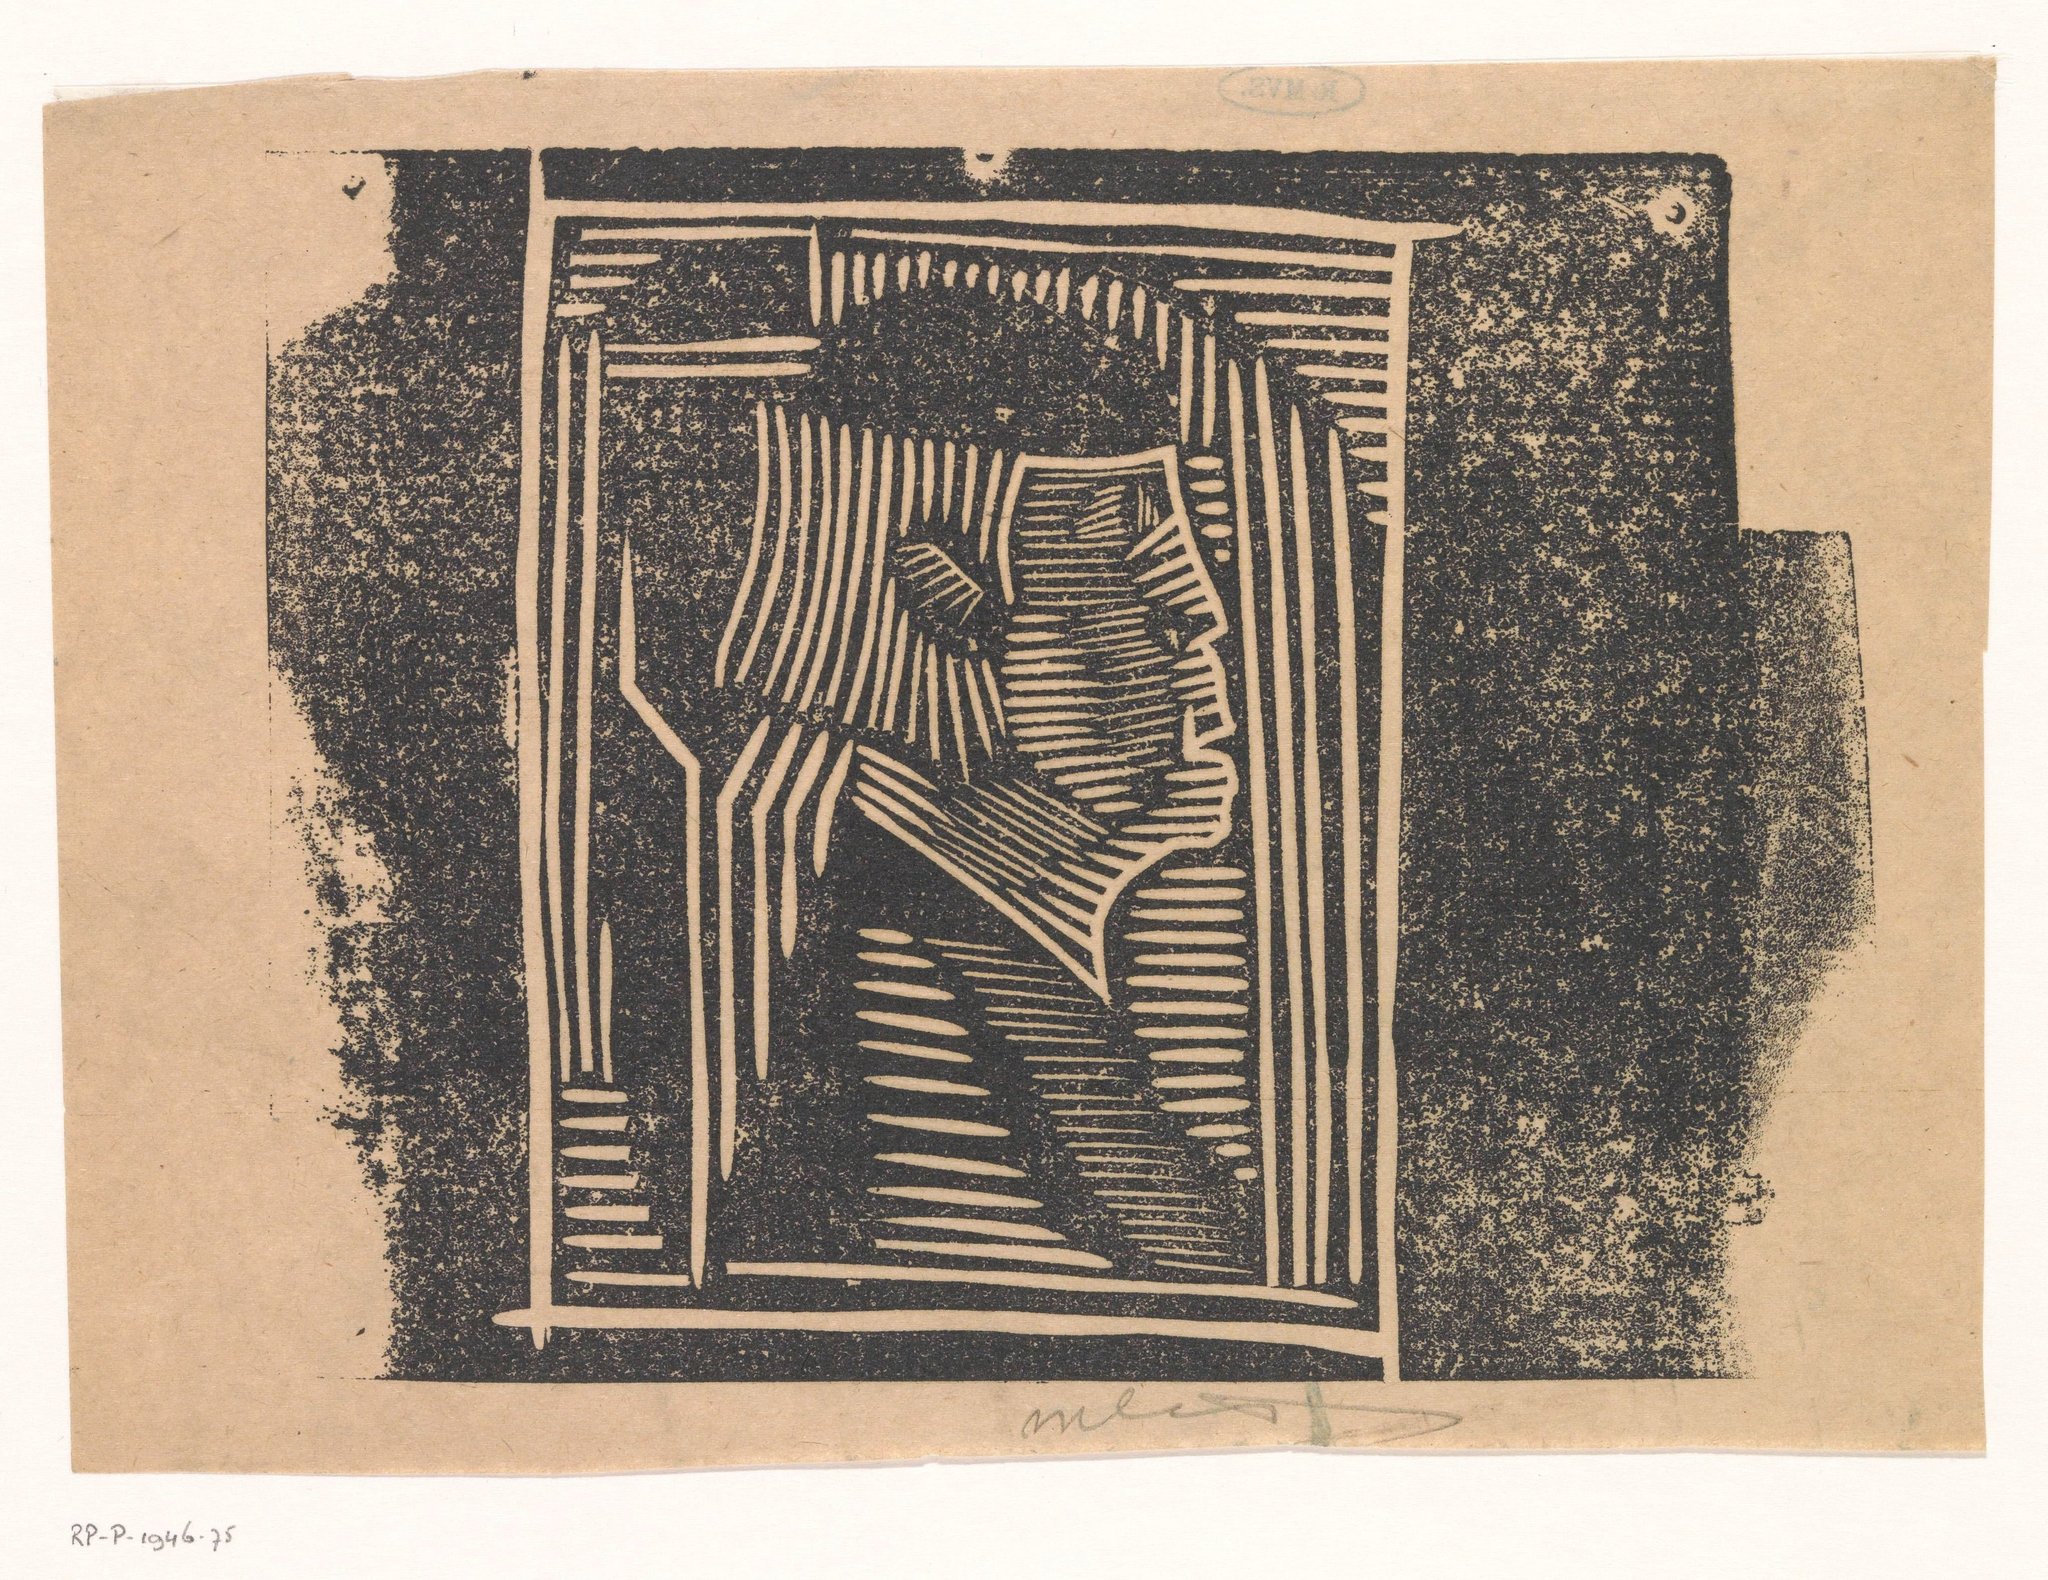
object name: print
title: Fantasiekop: profielkop in arceringen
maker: samuel jessurun de mesquita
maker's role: draughtsman, print maker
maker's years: 1868-1944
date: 1923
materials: paper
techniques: woodcut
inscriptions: signature: ‘mesquita’